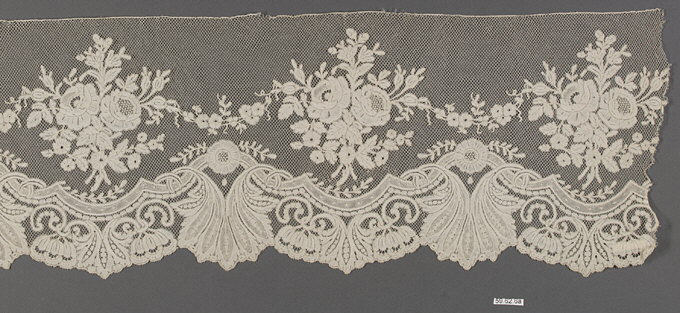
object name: edging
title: Edging (two pieces)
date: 1801-1900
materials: linen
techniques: lace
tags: flowers